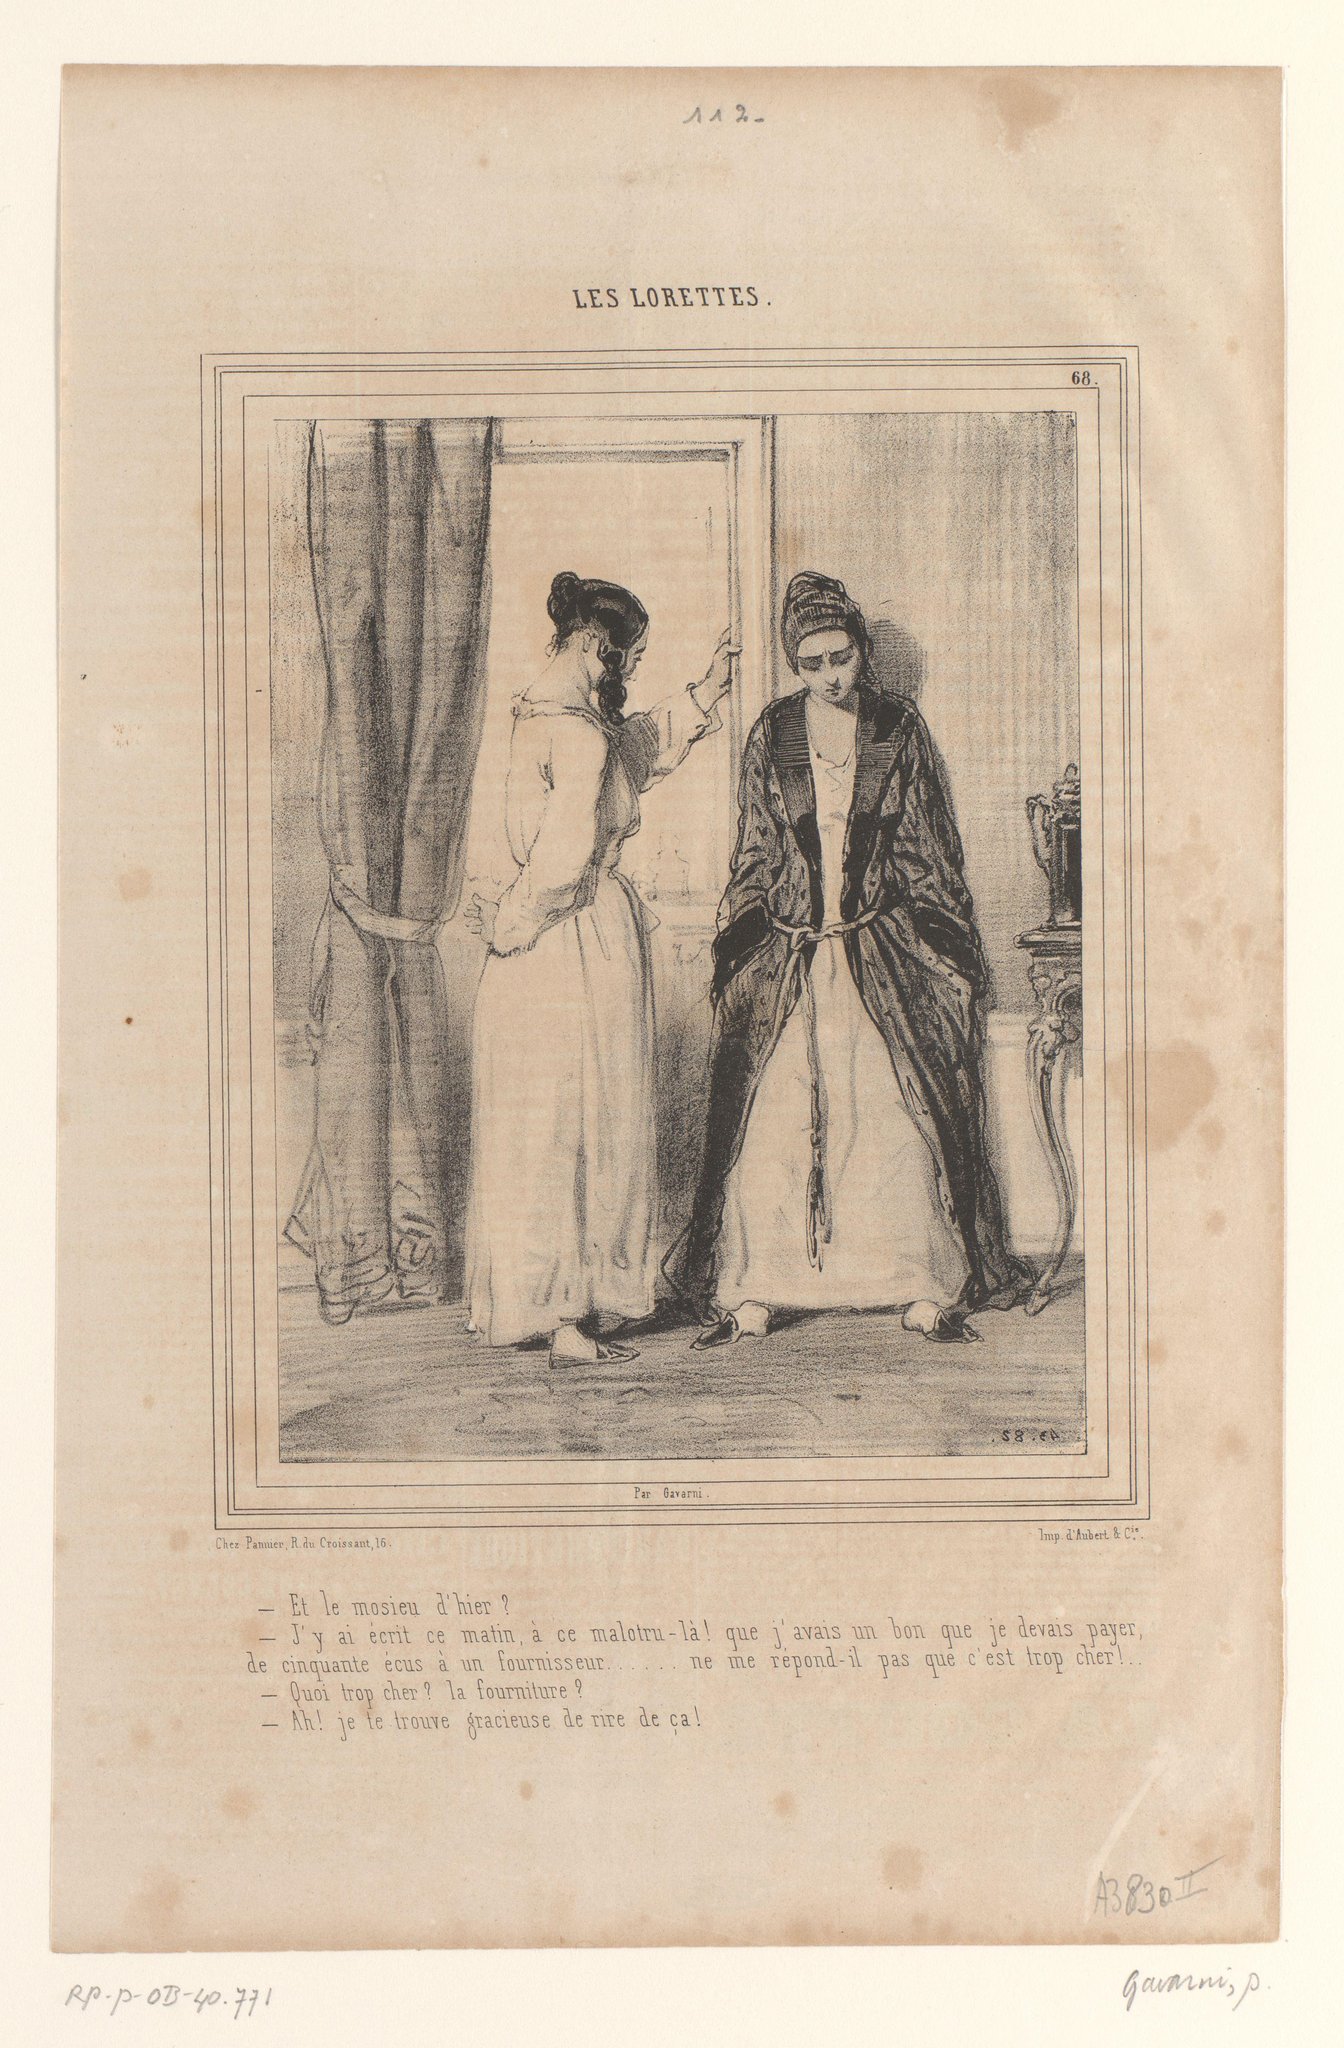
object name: print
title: Twee vrouwen spreken elkaar over gisteravond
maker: paul gavarni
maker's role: draughtsman, print maker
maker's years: 1804-1866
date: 1843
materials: paper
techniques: lithograph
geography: paris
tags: adult woman, conversation, dialogue; conversation piece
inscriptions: collector's mark: Lugt 2228a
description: Prent gebruikt voor: Le Charivari,11 september 1843.